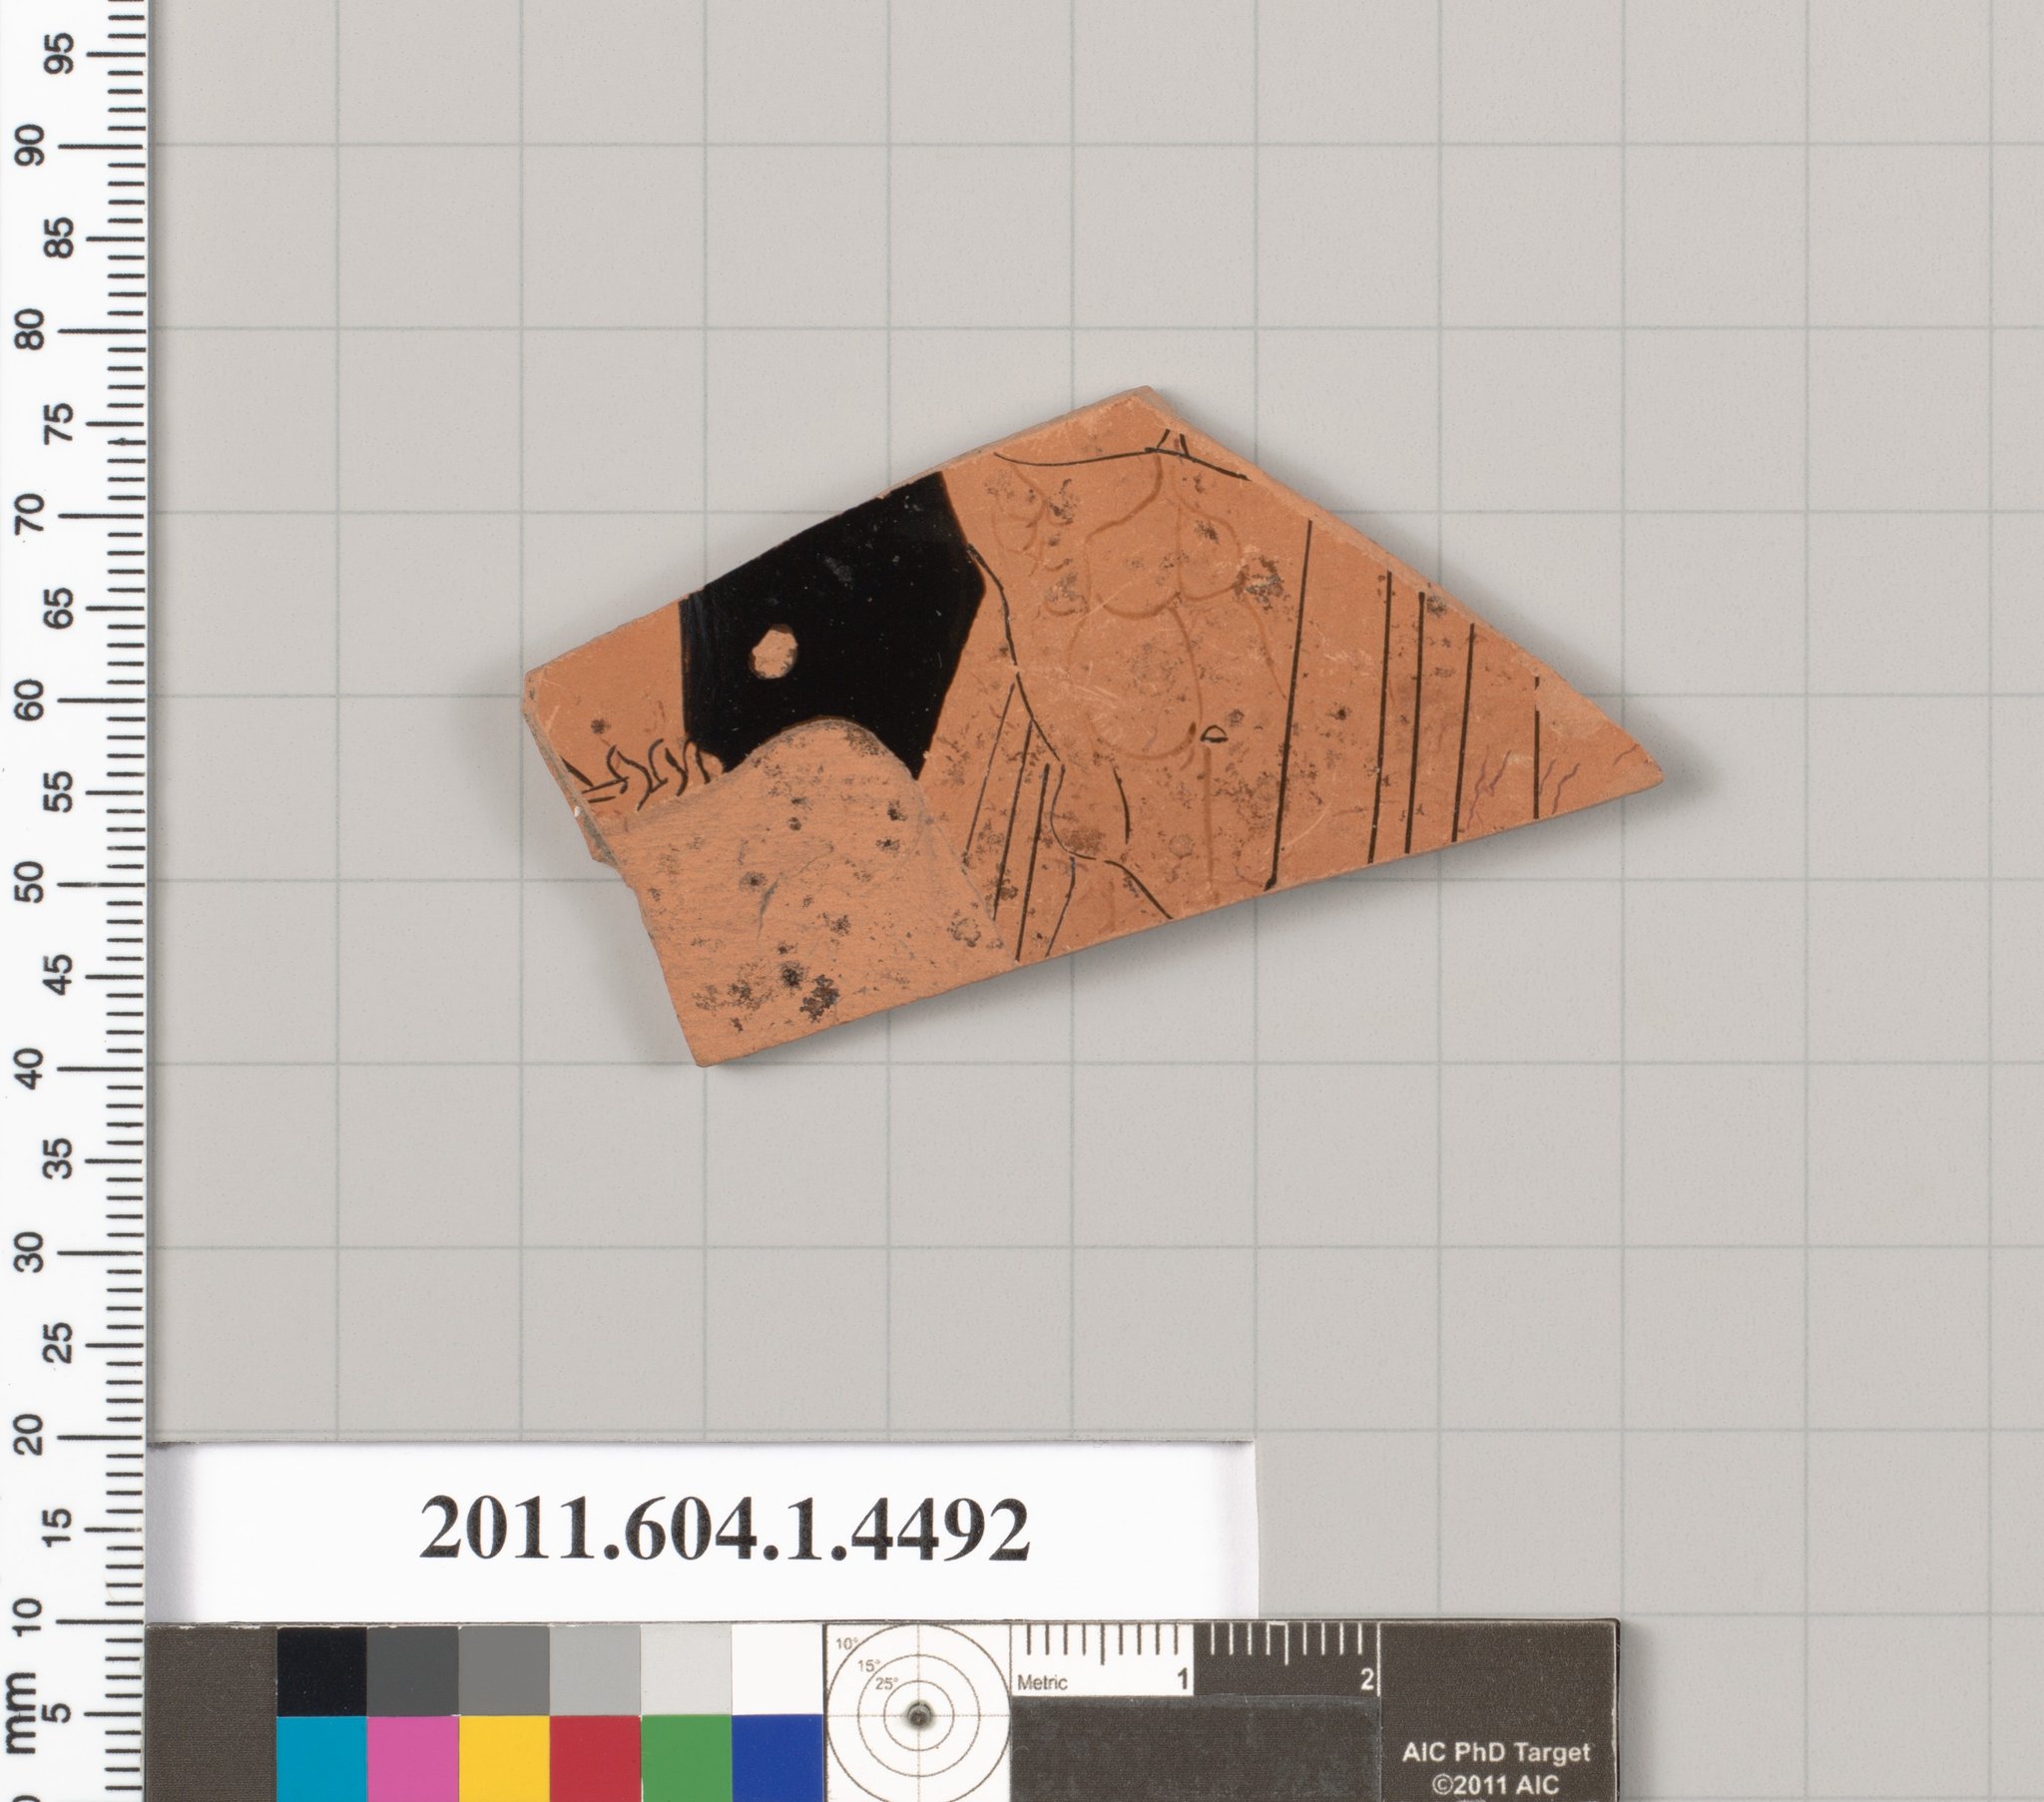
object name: kylix fragment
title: Terracotta fragment of a kylix (drinking cup)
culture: greek, attic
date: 490-470 BCE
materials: terracotta